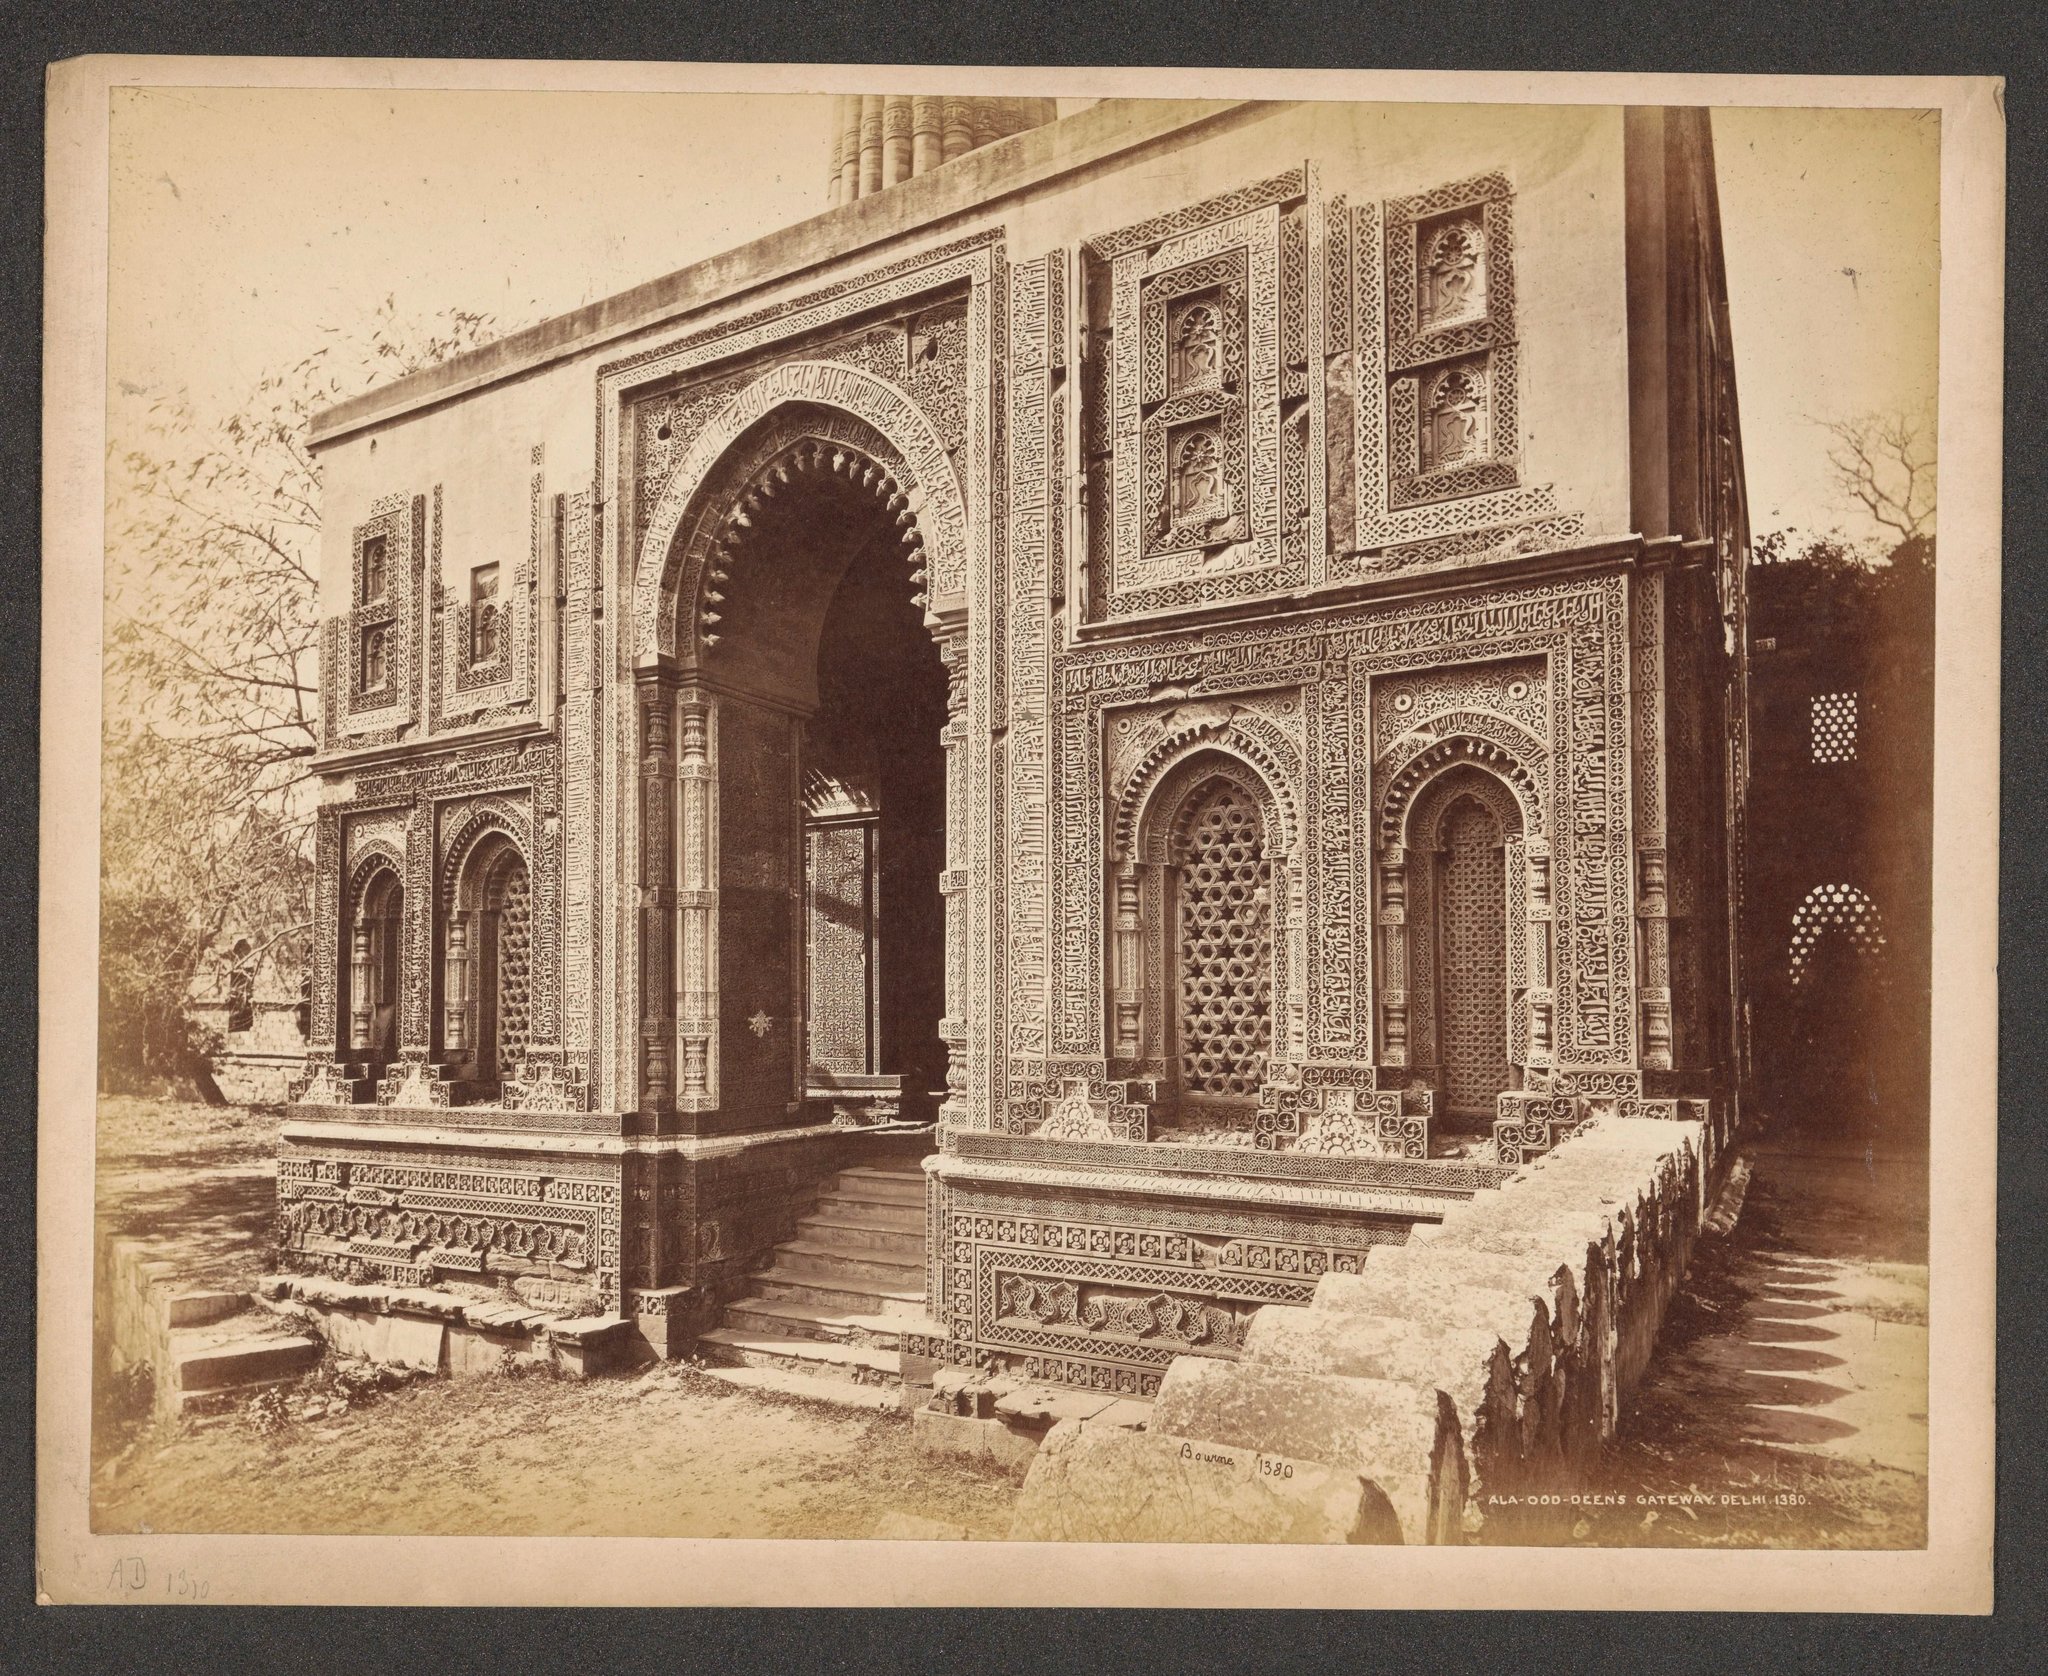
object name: photograph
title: Exterior of the Alai Darwaza at the Qutb complex, Delhi, India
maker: samuel bourne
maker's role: fotograaf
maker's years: 1834-1912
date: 1863-1866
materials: cardboard, paper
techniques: albumen print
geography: delhi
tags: gate, entrance, temple, shrine ~ islam, mohammedanism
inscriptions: title: ‘Ala-ooo-deen's Gateway. Delhi.’, inscription: ‘AD 1310’, number: ‘38’, name: ‘Bourne’, number: ‘1380’